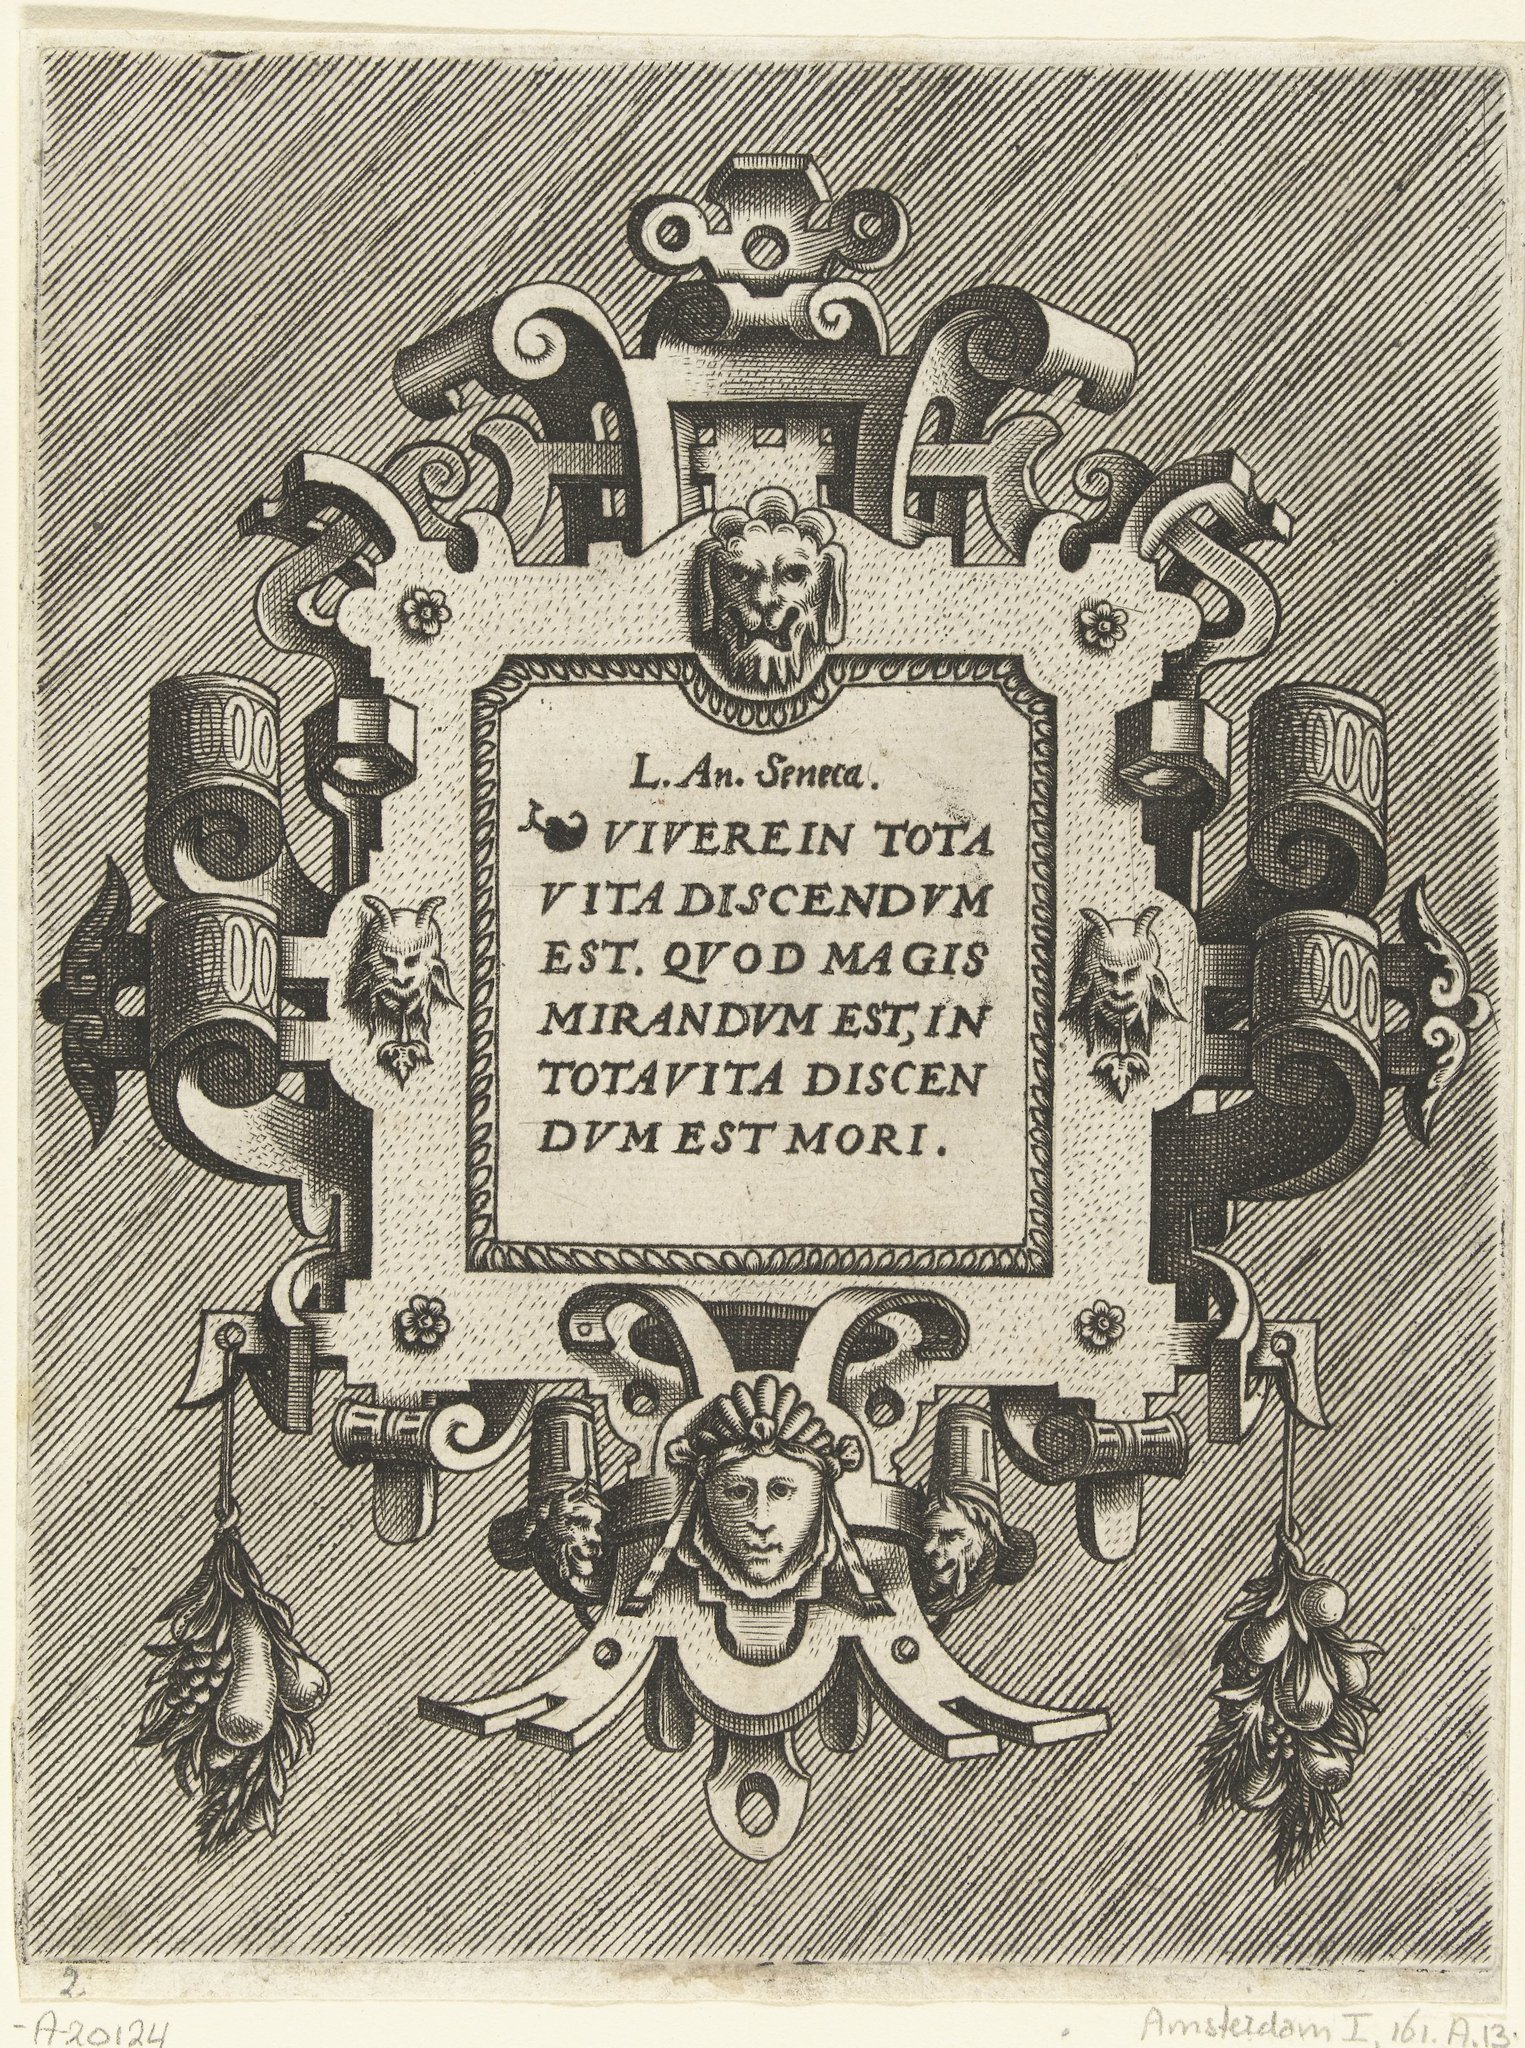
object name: print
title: Cartouche met een citaat van Seneca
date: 1557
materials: paper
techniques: etching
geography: netherlands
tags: fruits and vegetables ~ ornament, ornament ~ cartouche, mask, mascaron ~ ornament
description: Citaat: VIVERE IN TOTA VITA DISCENDVM EST in cartouche. Het citaat wordt in deze editie vooraf gegaan door een rankje (ipv handje) als aandachtsteken.Op de cartouche zitten zes mascarons. Links- en rechtsonder hangt een fruittros. Gearceerde achtergrond. Uit tweede editie van serie bestaande uit een titelblad en 12 cartouches met citaten van klassieke schrijvers in een omlijsting van rolwerk met grotesken, mascarons en guirlandes.